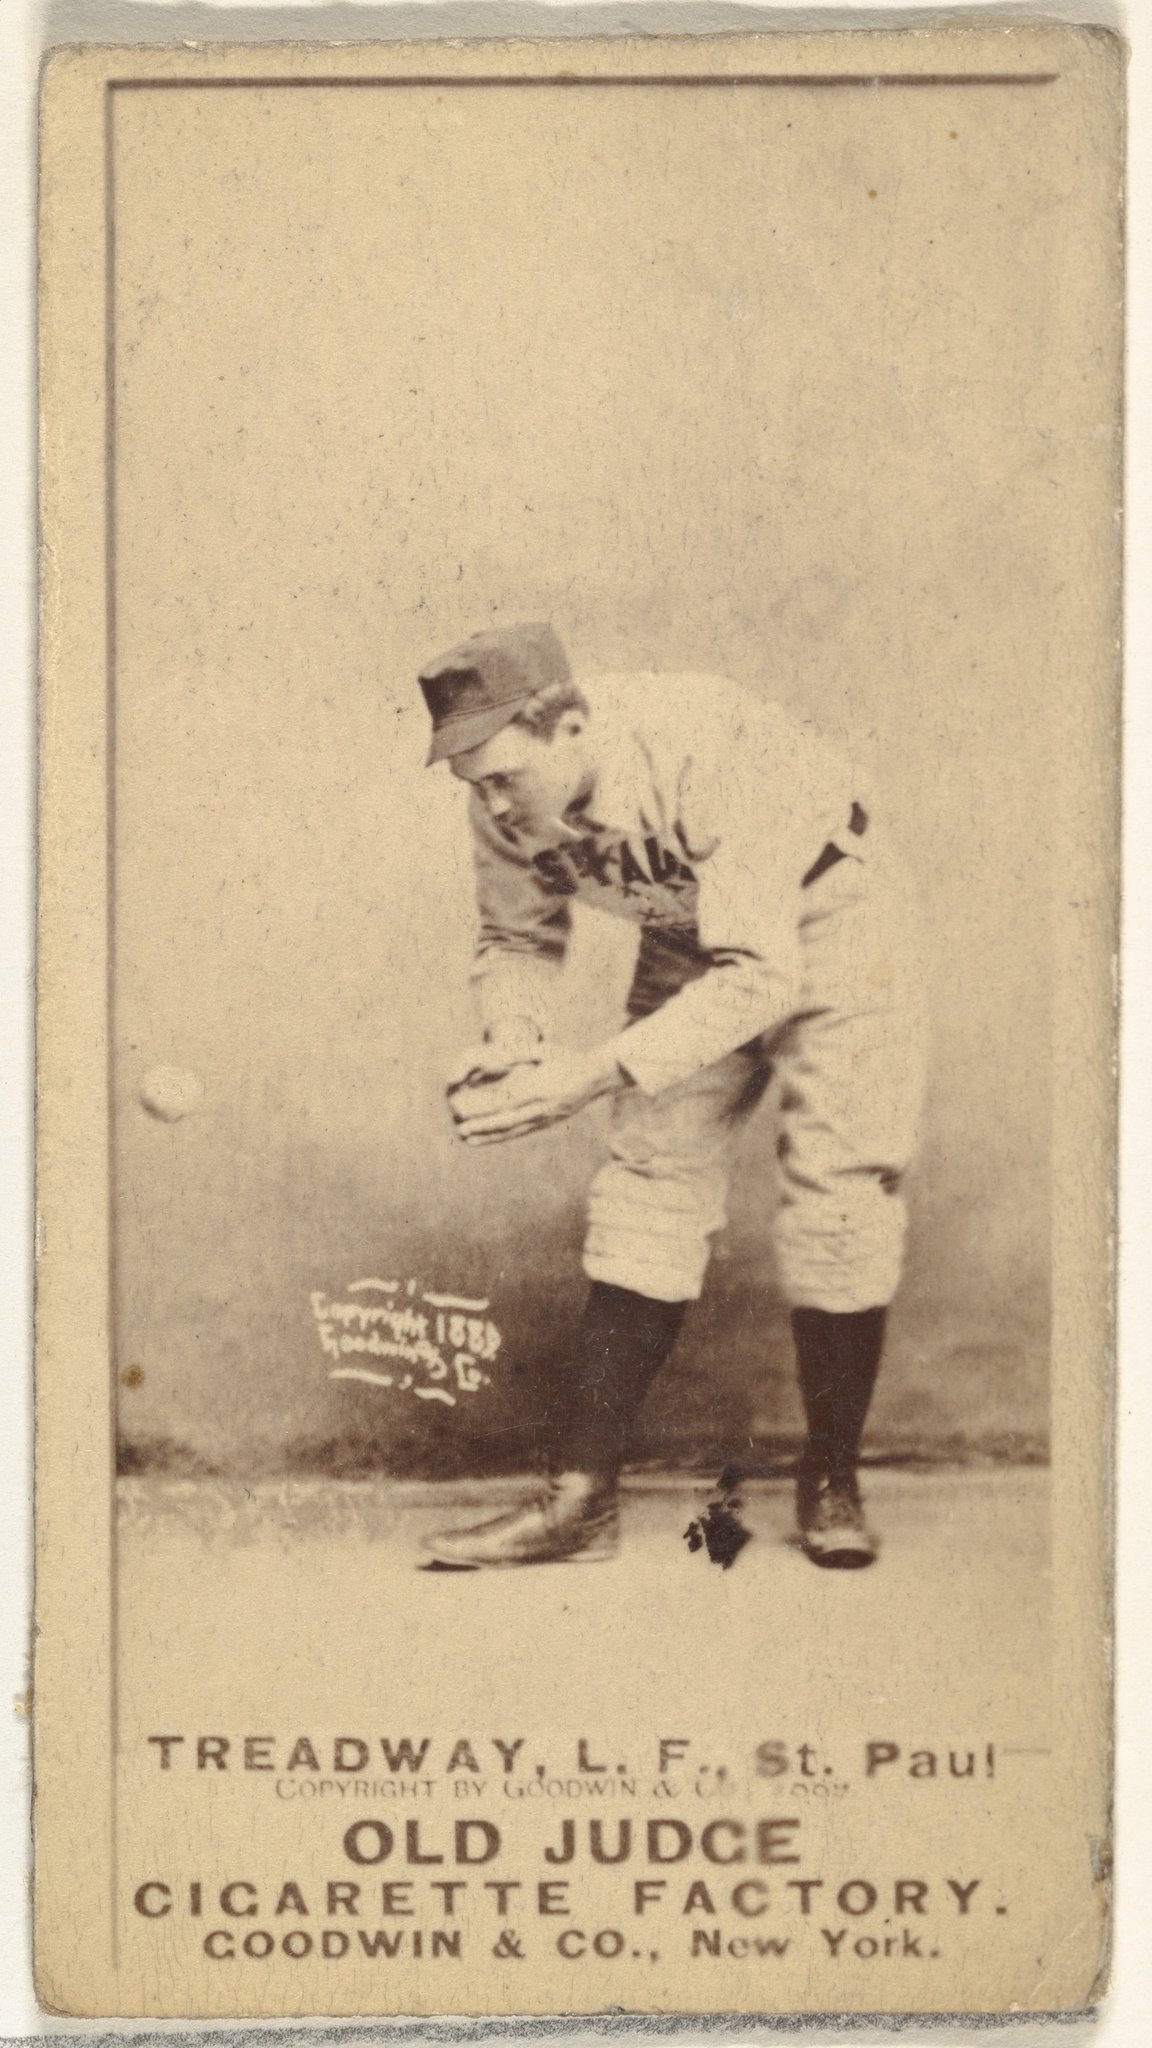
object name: baseball card, photograph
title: George B. Treadway, Left Field, St. Paul Apostles, from the Old Judge series (N172) for Old Judge Cigarettes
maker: goodwin & company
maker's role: publisher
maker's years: 1850-1950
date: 1888-1889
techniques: albumen silver print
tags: men,portraits,baseball,athletes